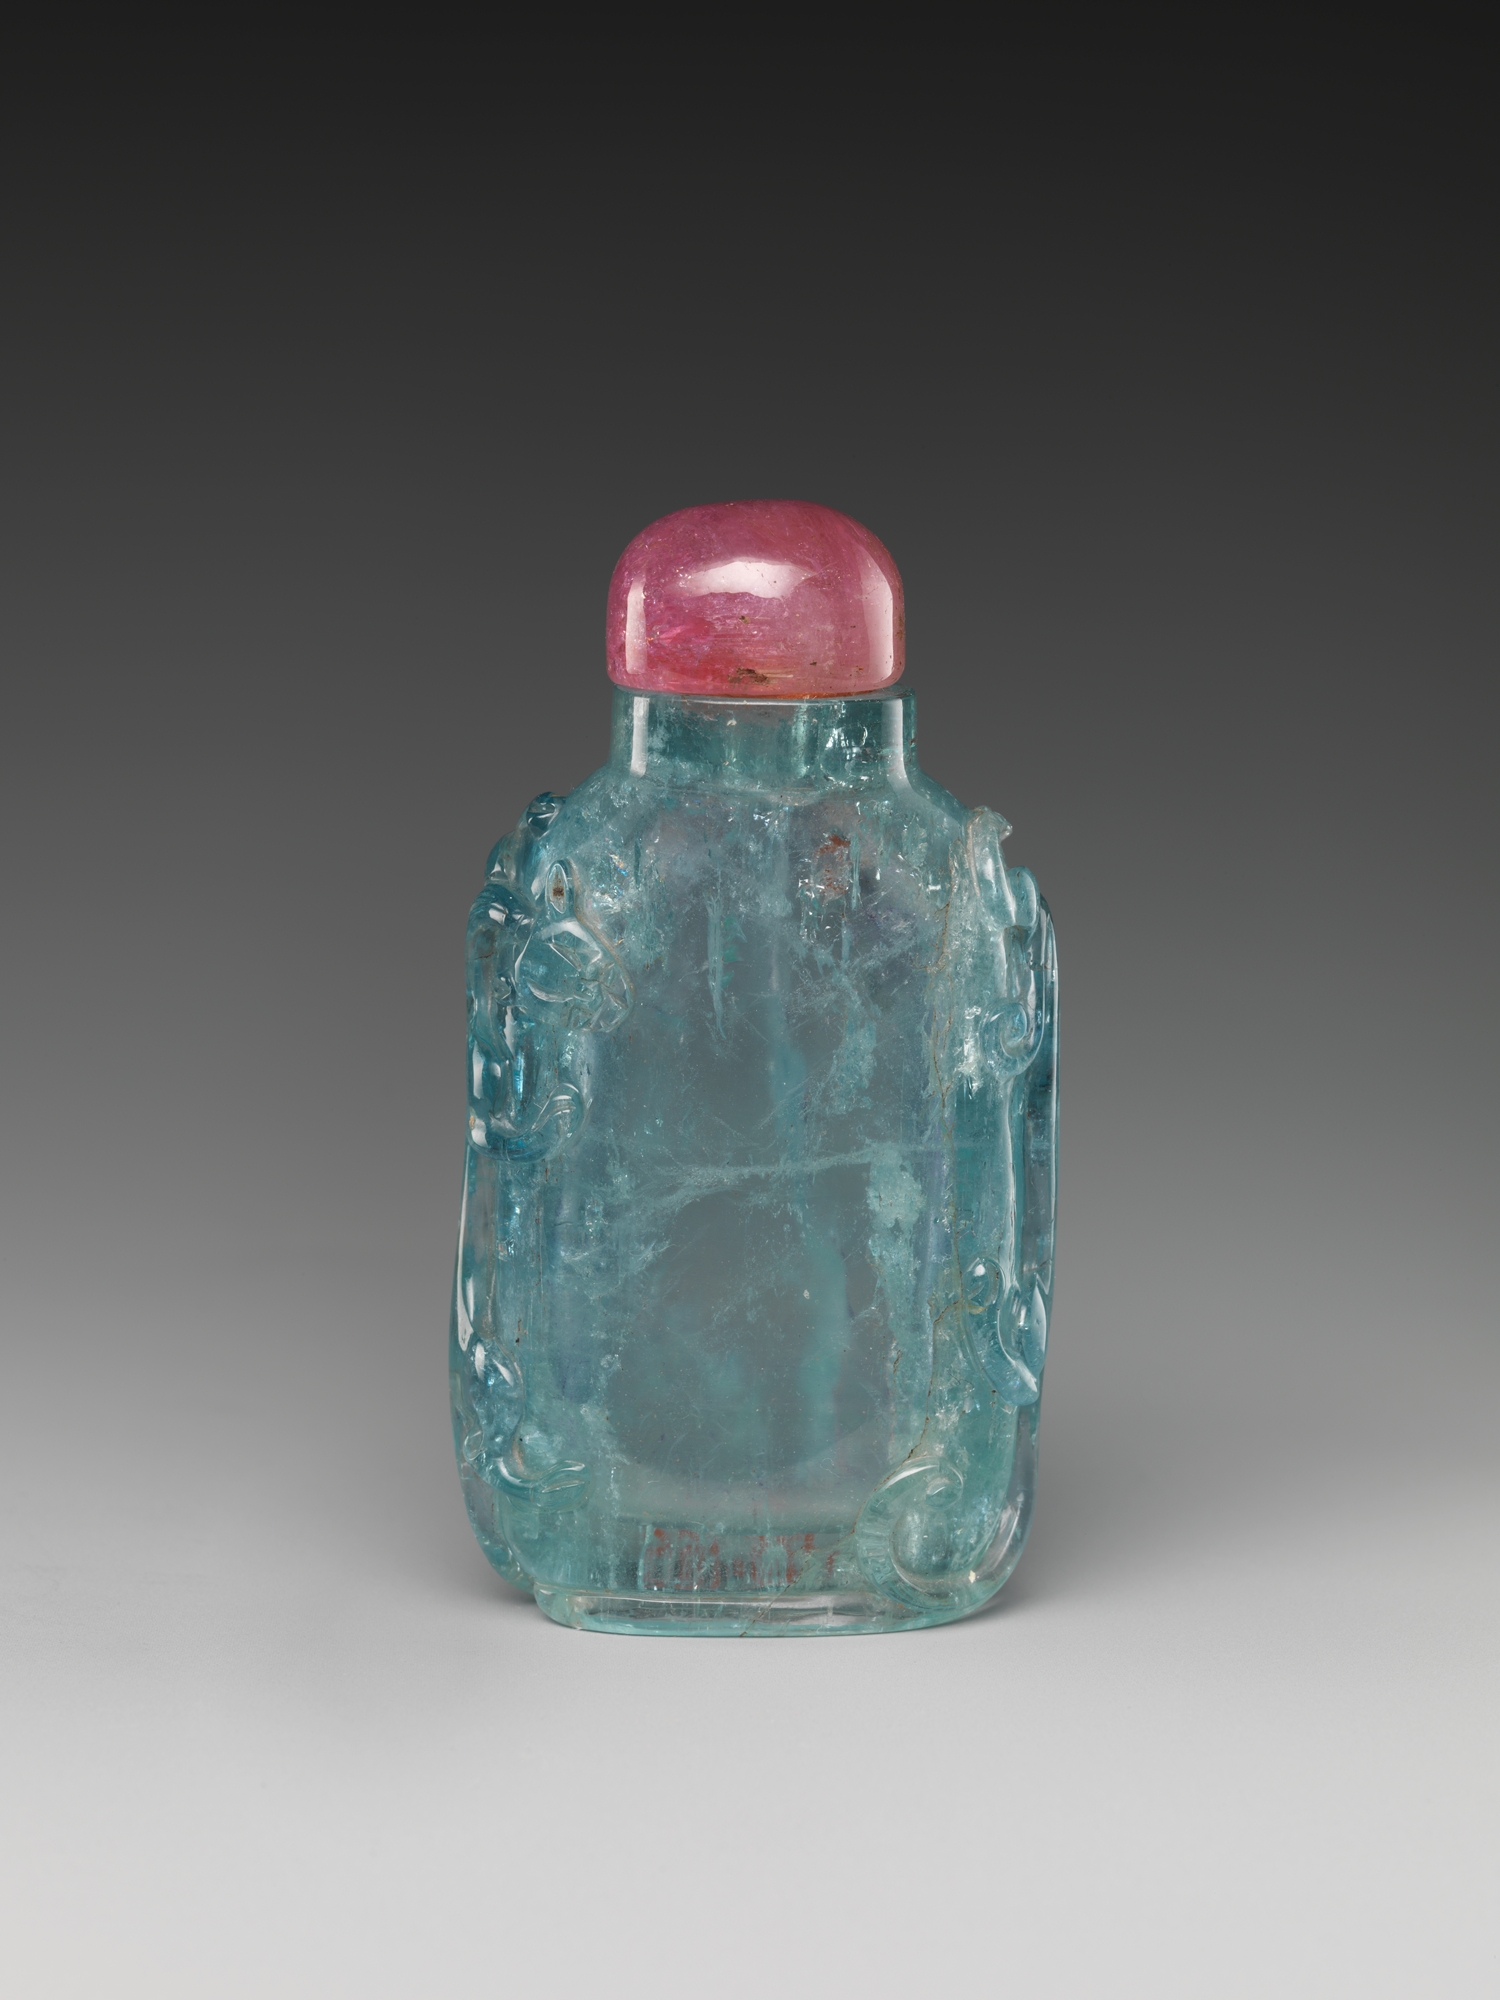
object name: snuff bottle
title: Snuff Bottle with Floral Design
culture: chinese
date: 1767-1800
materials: gemstone, quartz